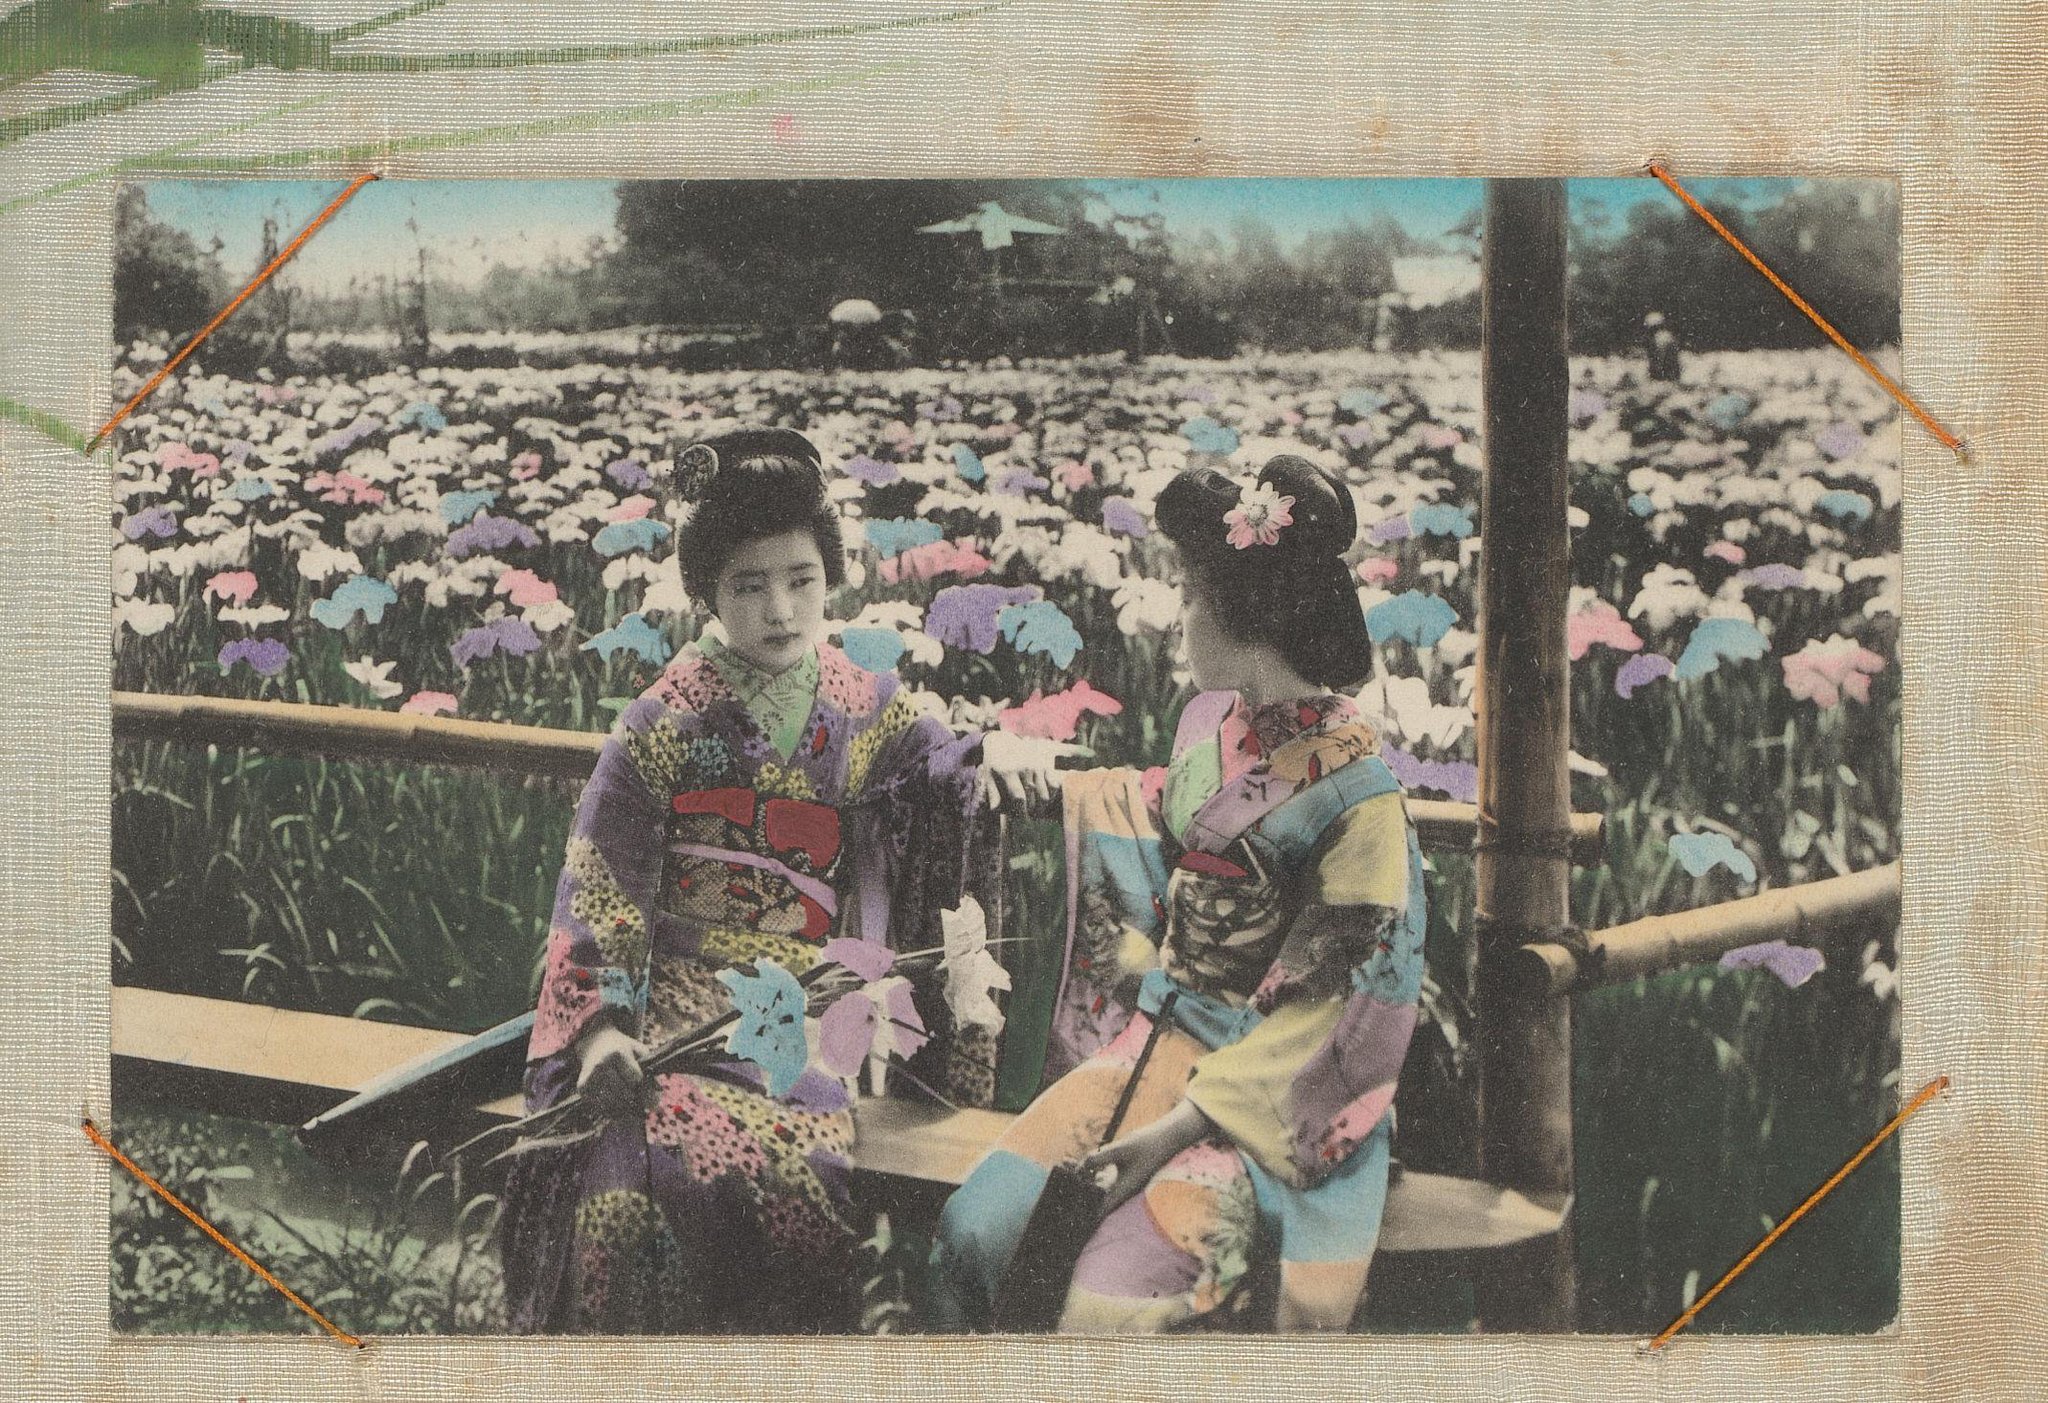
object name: photomechanical print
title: Twee Japanse vrouwen in gekleurde kimono's, zittend op een bank voor een bloemenveld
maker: Anonymous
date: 1900-1920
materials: paper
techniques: photograph, hand coloring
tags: flower culture, historical persons (+ all kinds of 'portrait historié': mythological portrait, allegorical portrait, 'rollenporträt', etc.)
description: Deze prent maakt deel uit van een album.